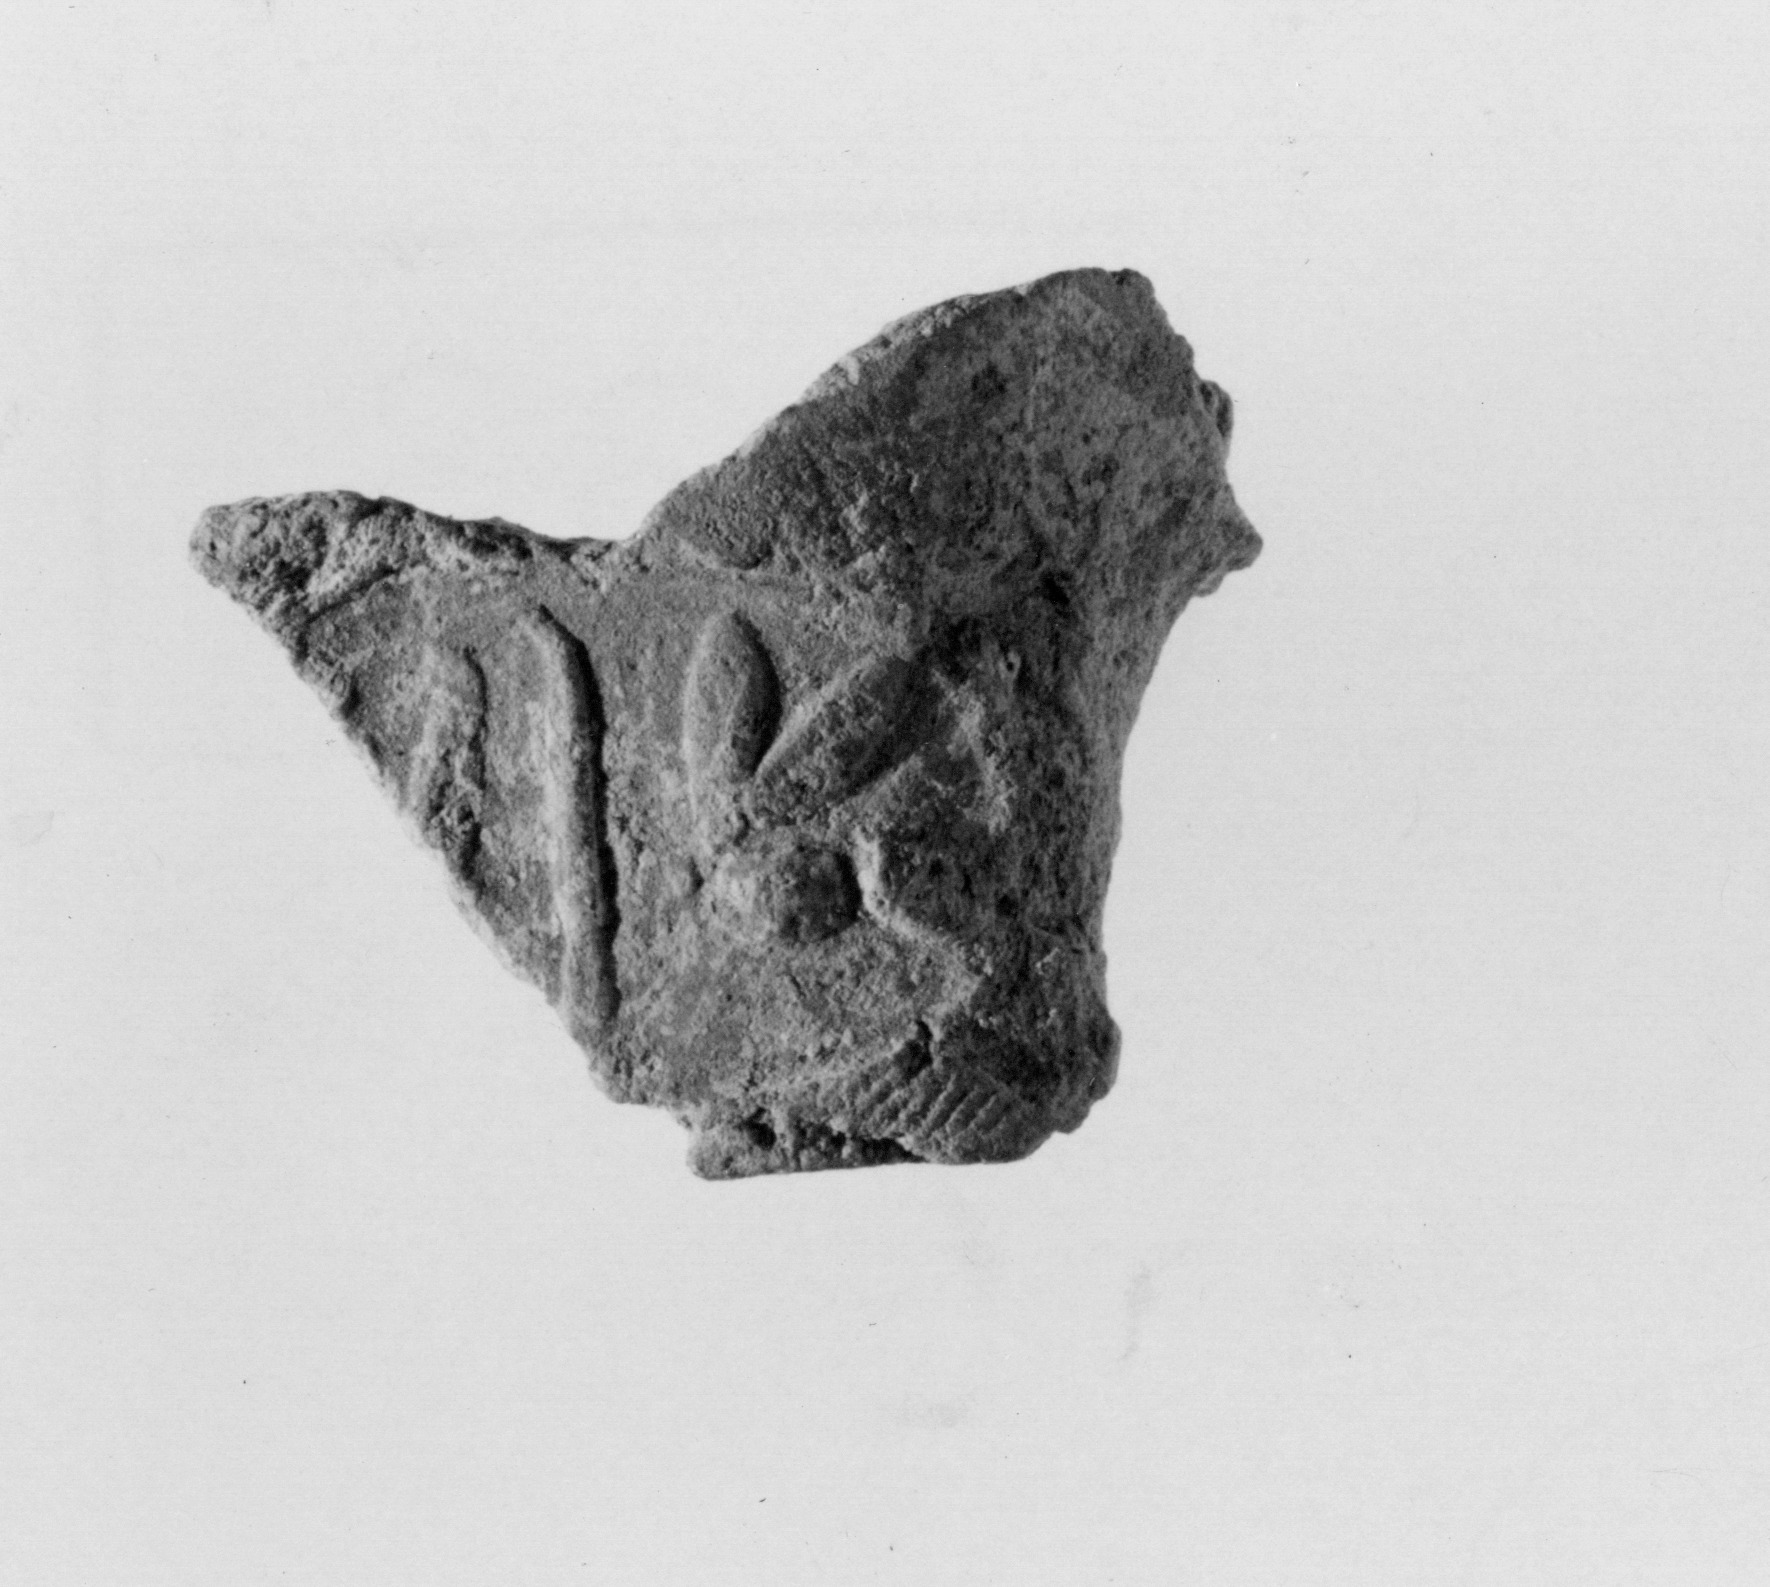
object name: sealing, nebmaatre, amenhotep iii, nesut, bity, bee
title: Document Sealing with the Throne Name of Amenhotep III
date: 1390-1352 BCE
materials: mud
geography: egypt